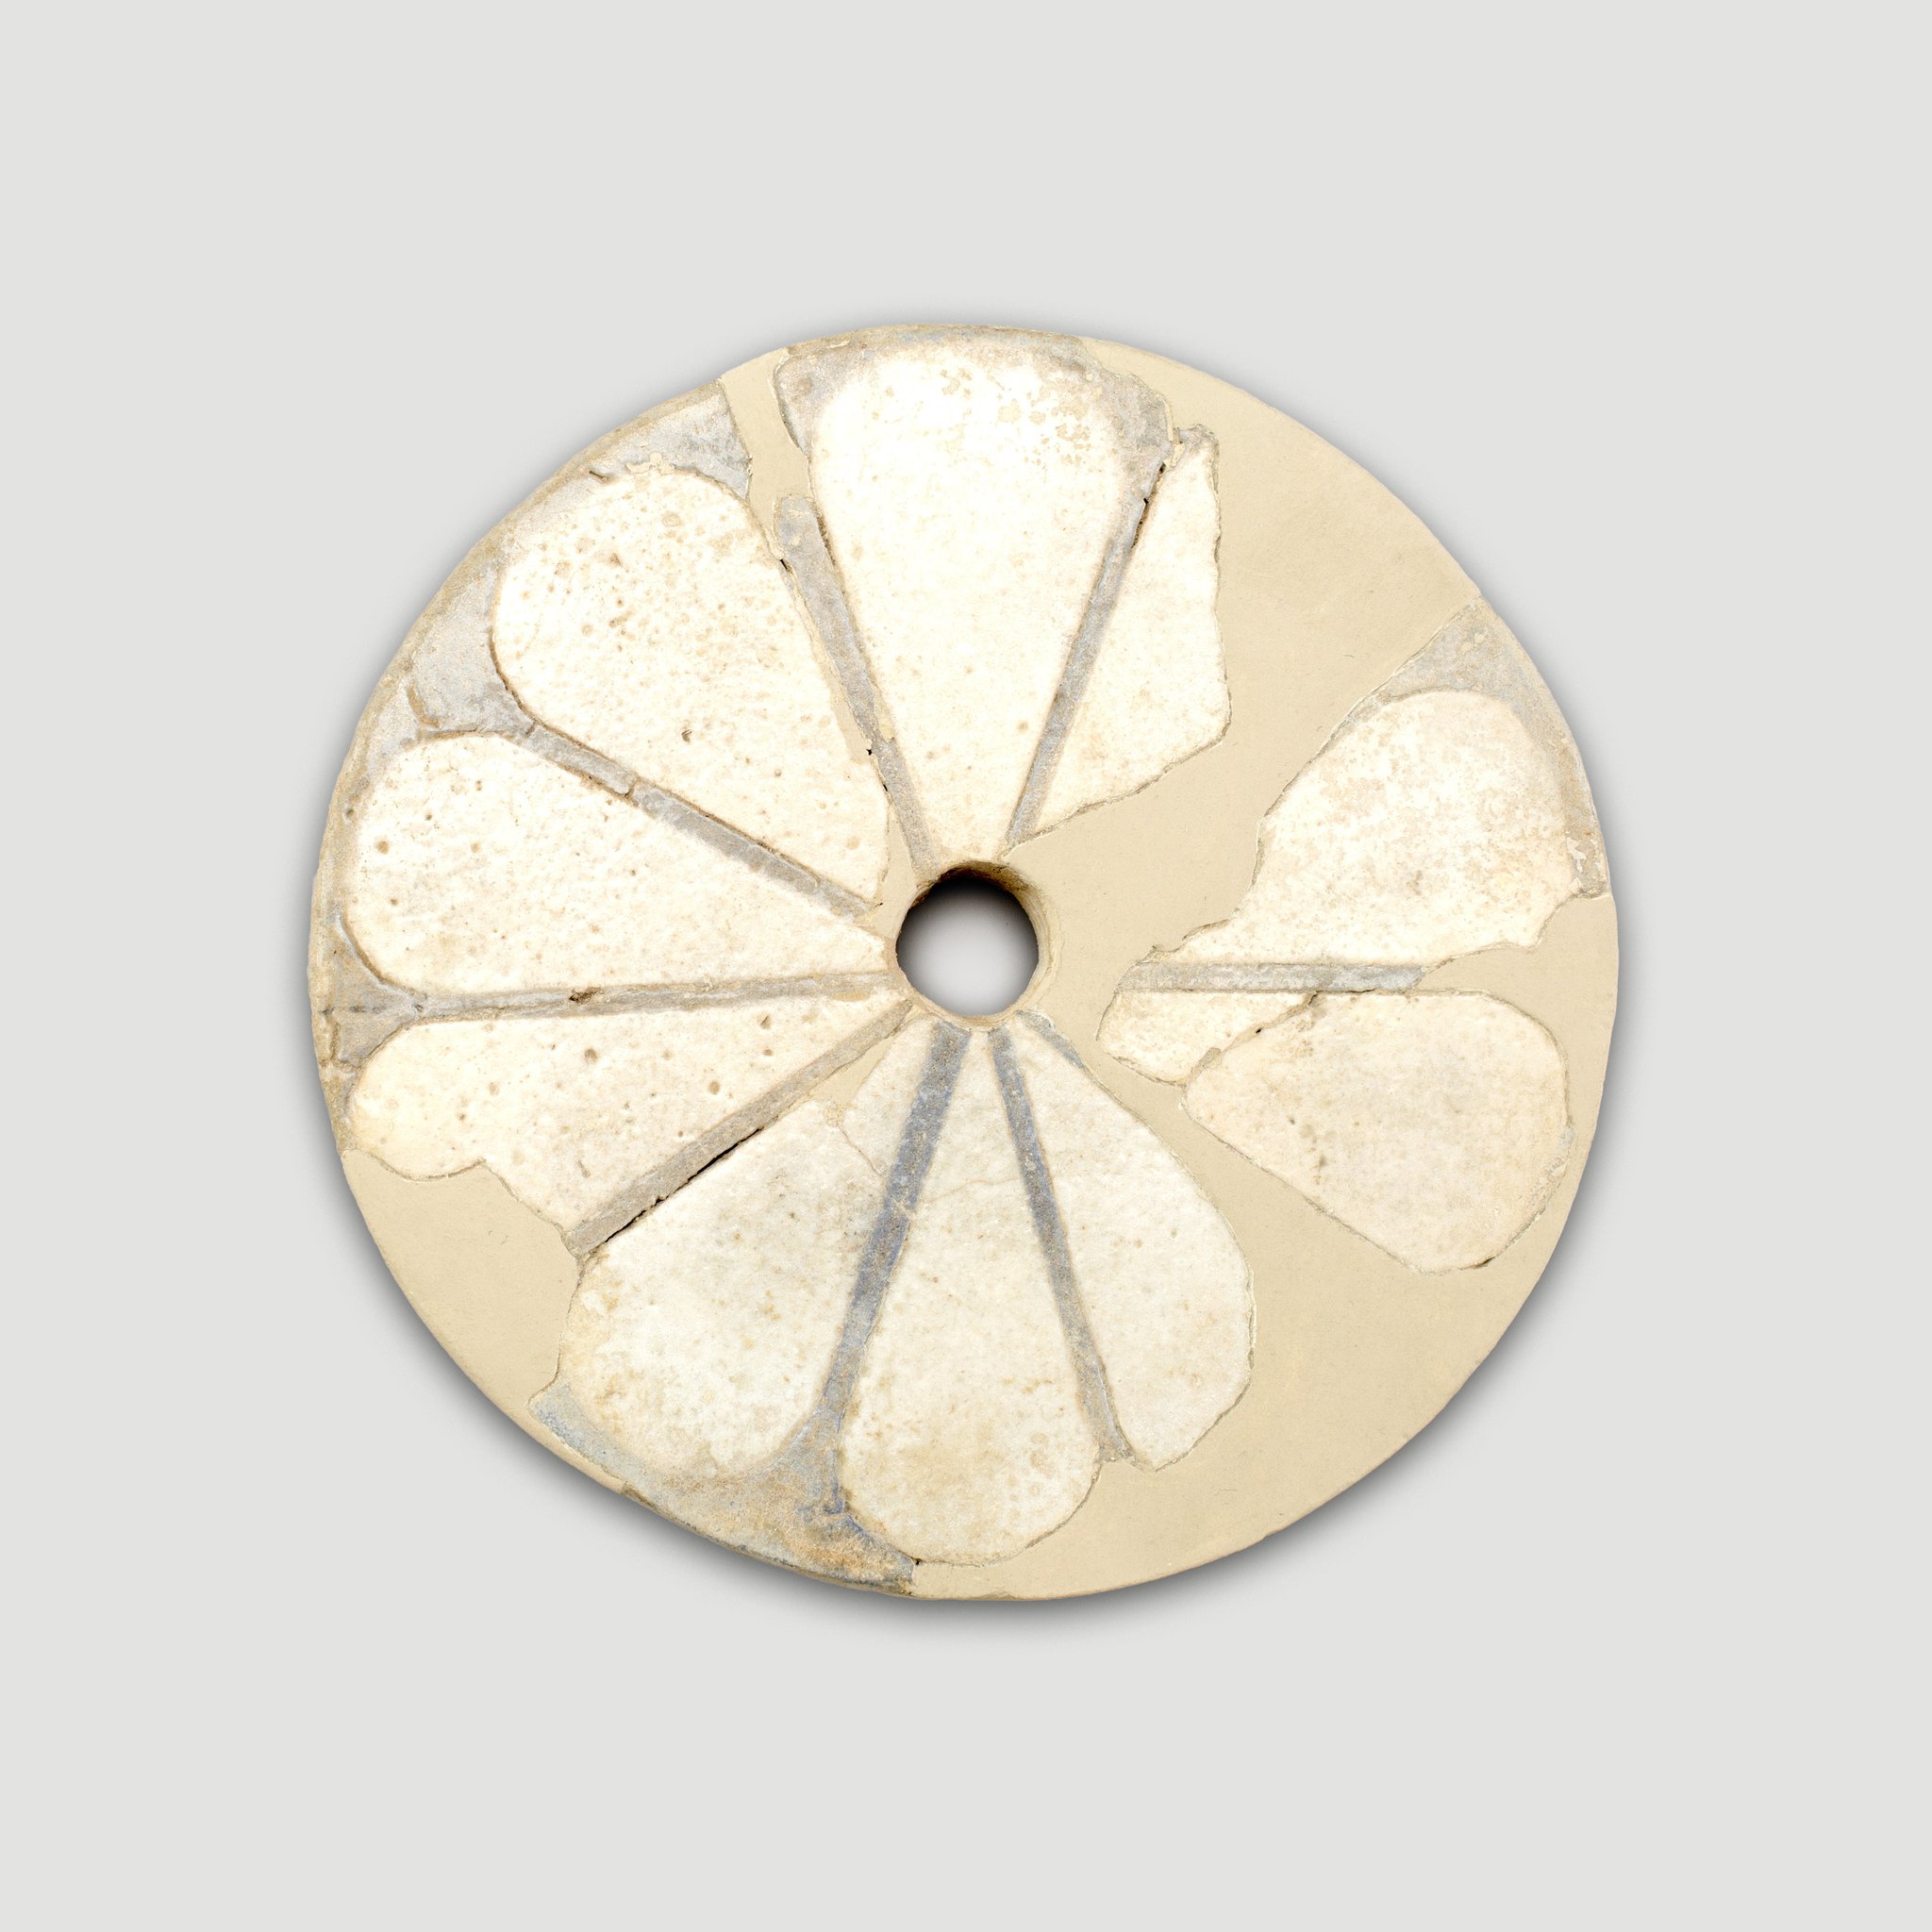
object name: tile, palace of ramesses ii, rosette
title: Tiles and ornaments from the palace of Ramesses II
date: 1279-1213 BCE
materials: faience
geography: egypt